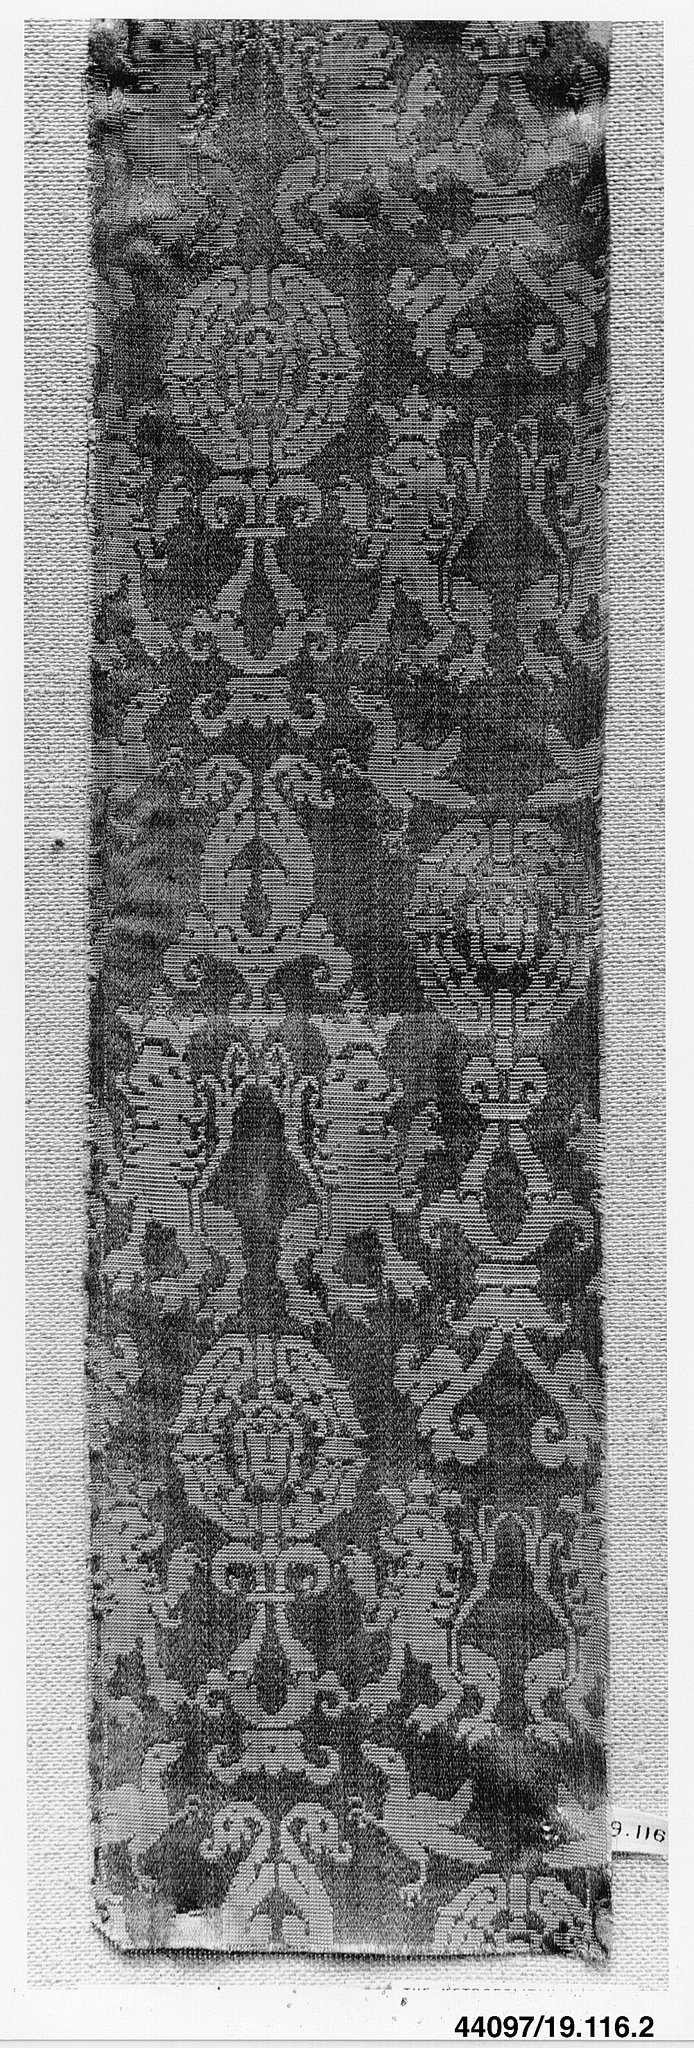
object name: piece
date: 1601-1633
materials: silk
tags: animals